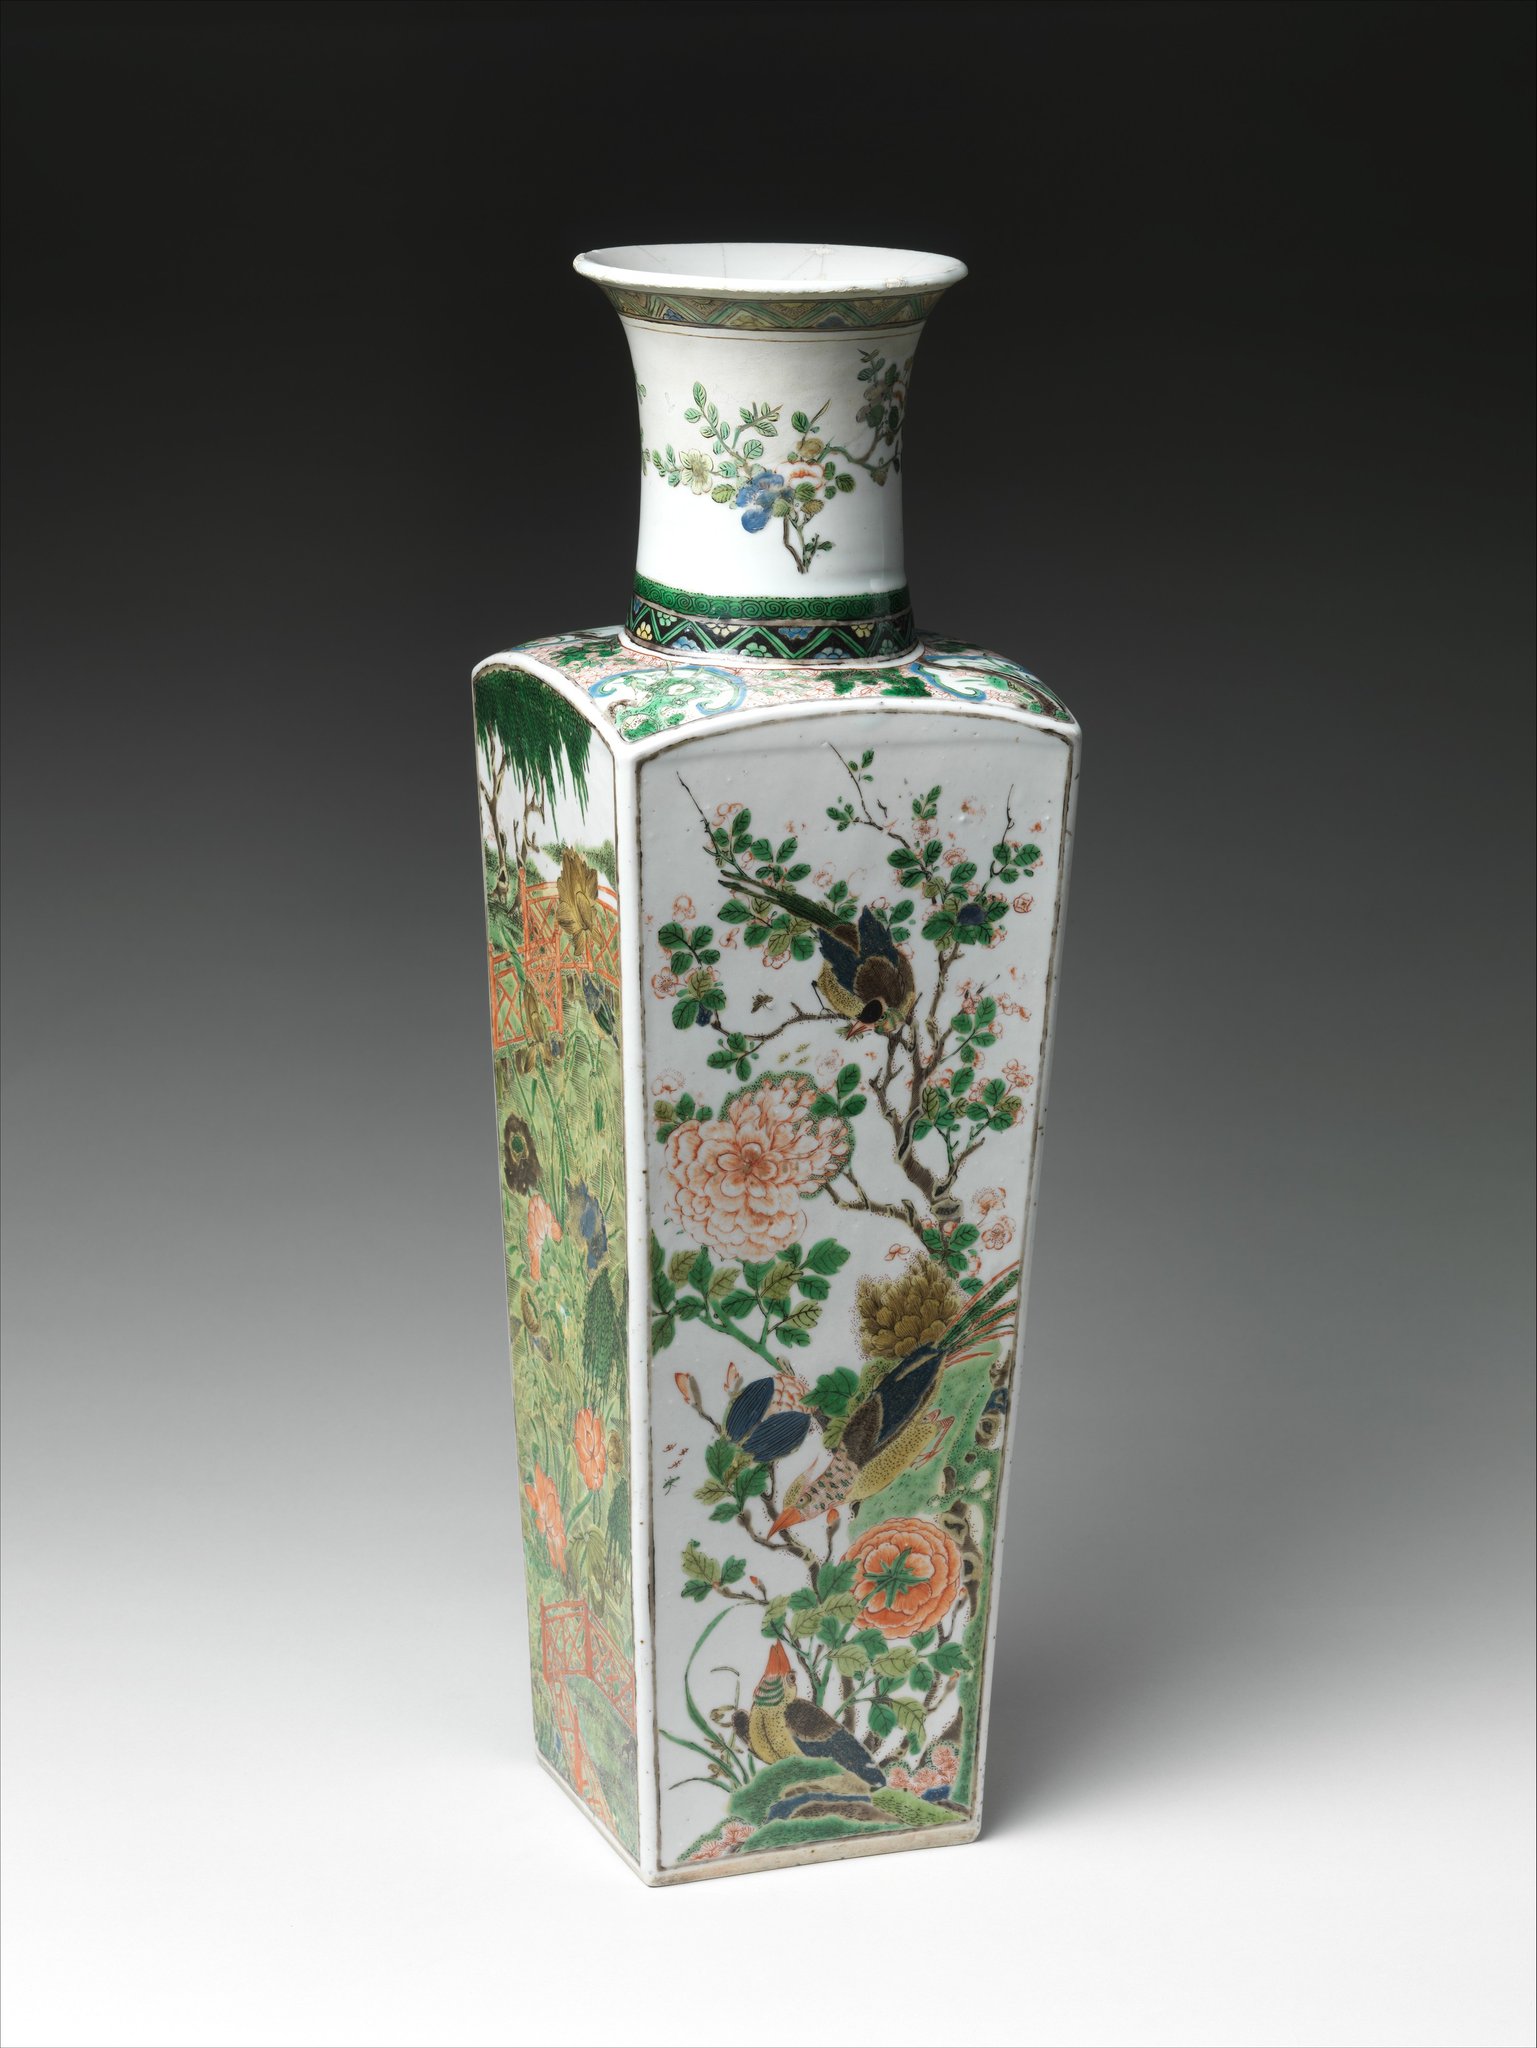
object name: vase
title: Vase with flowers and birds of the four seasons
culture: chinese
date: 1701-1733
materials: enamel, porcelain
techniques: overglaze, painting, polychrome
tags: birds,flowers,leaves